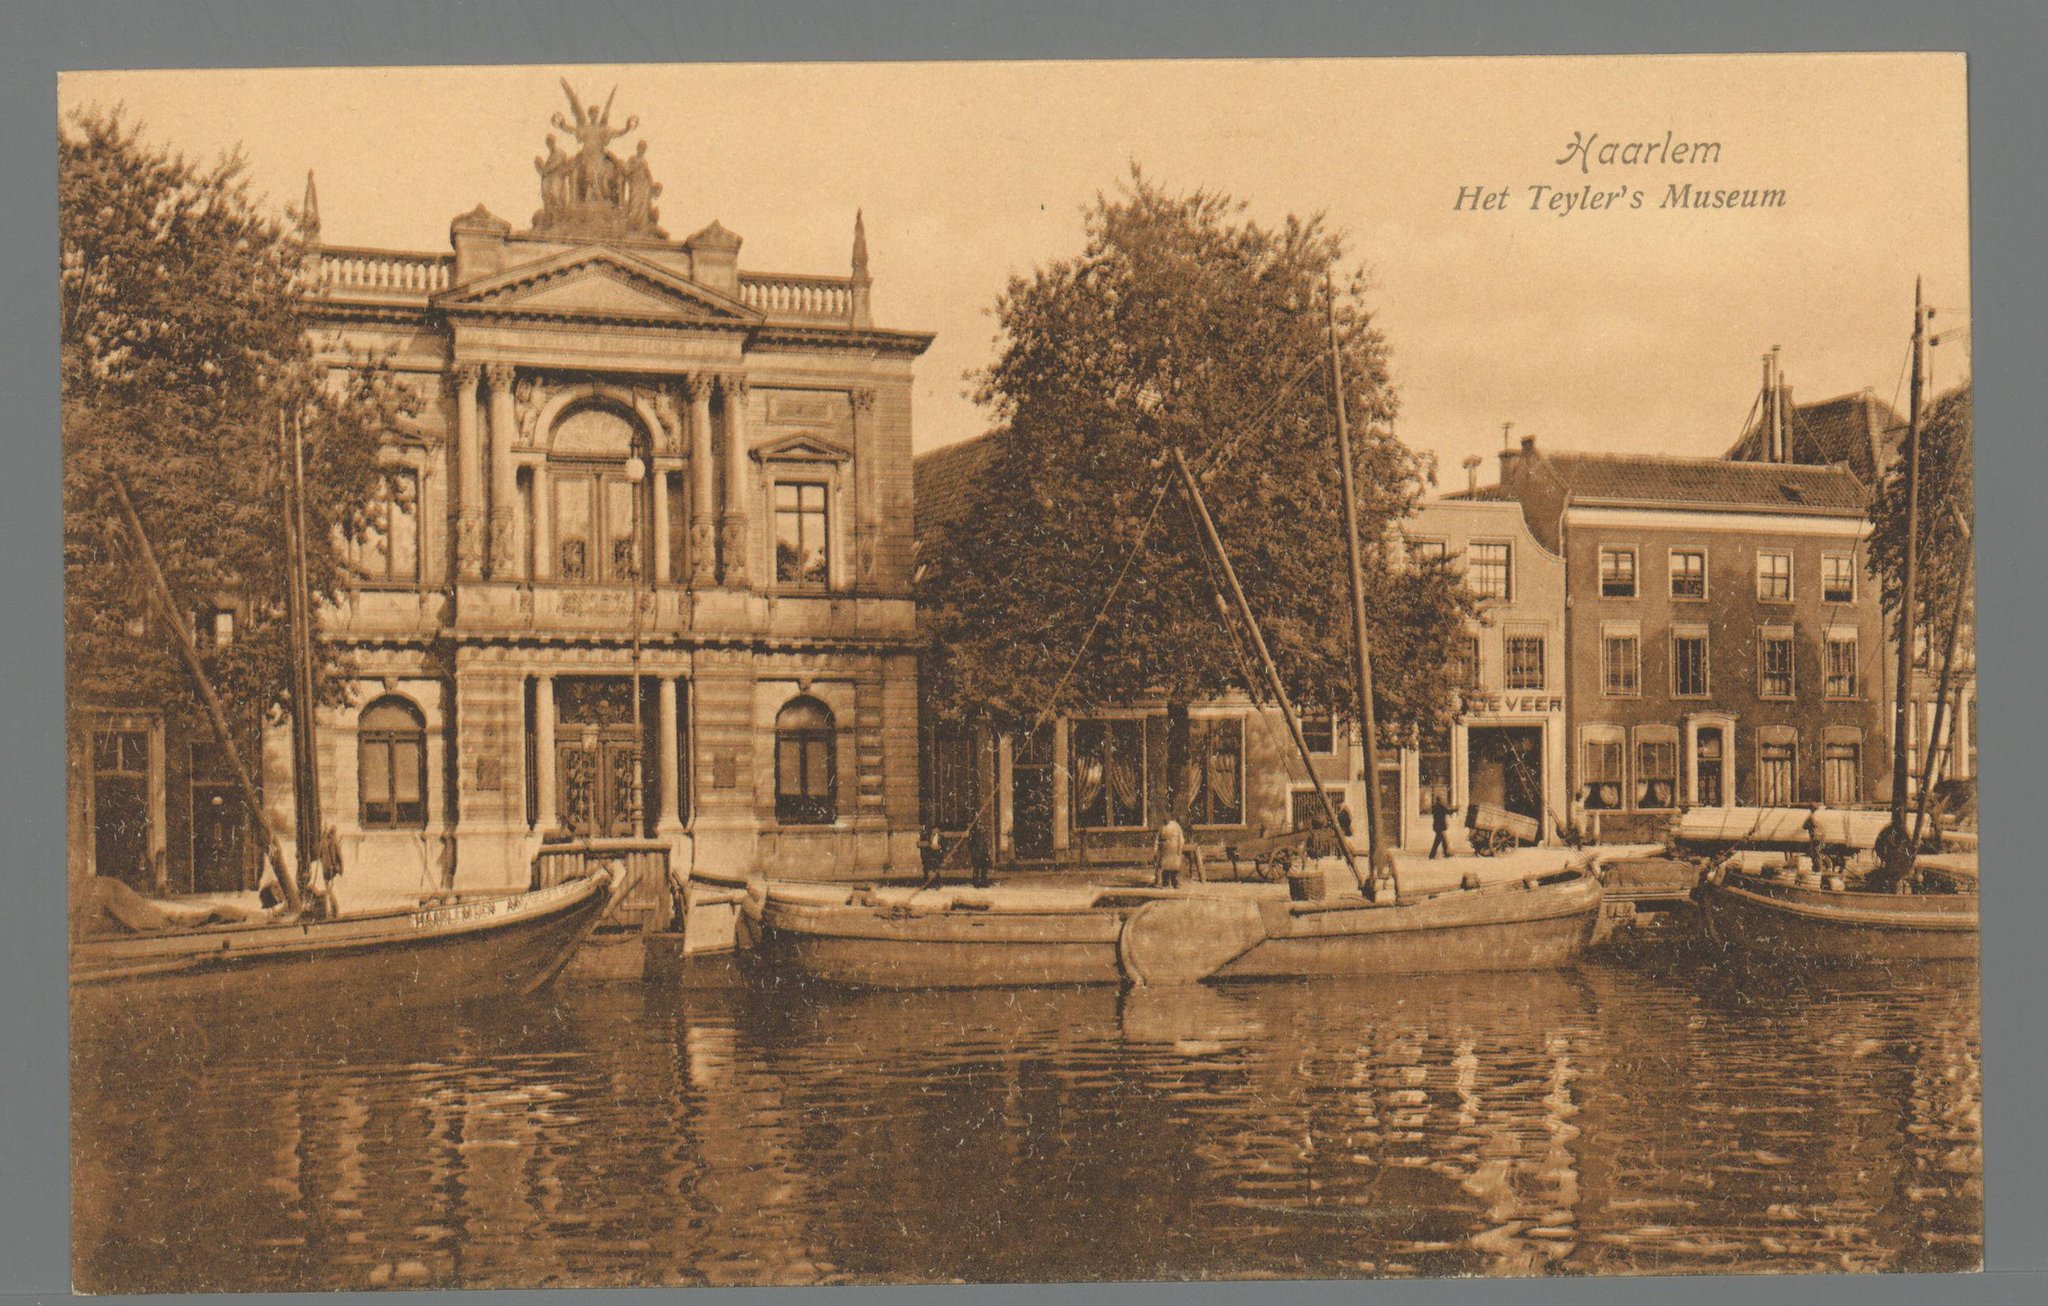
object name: photomechanical print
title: Haarlem. Het Teyler's Museum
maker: Anonymous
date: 1911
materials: cardboard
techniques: photograph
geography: the hague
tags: city-view, and landscape with man-made constructions, sailing-ship, sailing-boat, canal, permanent exhibition, museum, haarlem